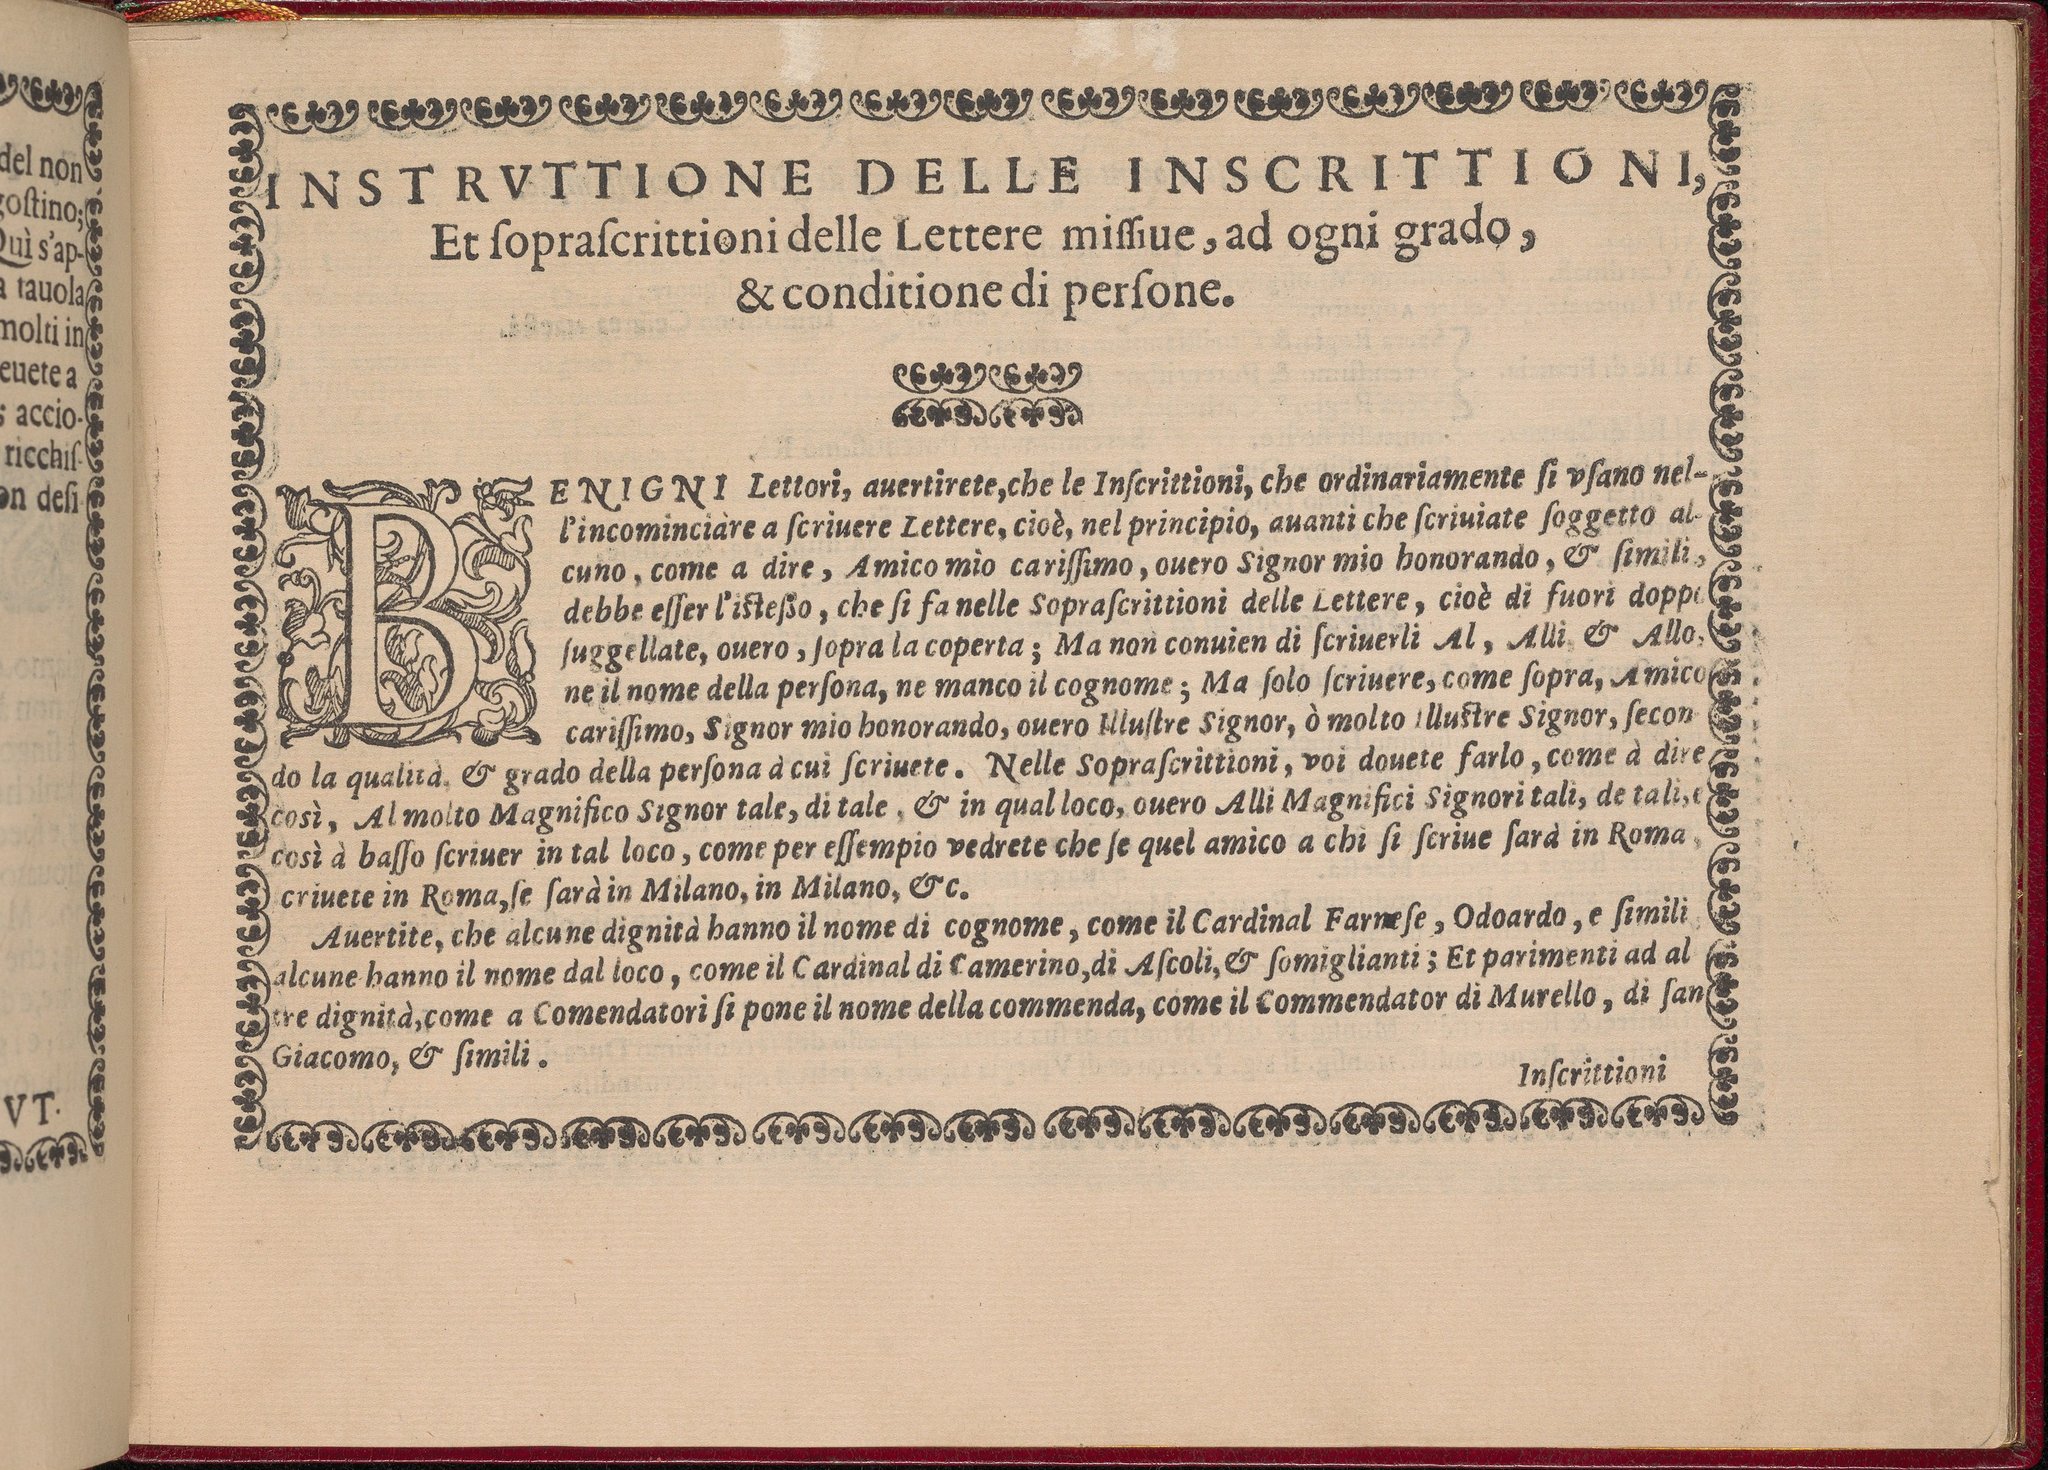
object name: book print ornament architecture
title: Ghirlanda: Di sei vaghi fiori scielti da piu famosi Giardini d'Italia, page 4 (recto)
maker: pietro paulo tozzi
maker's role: designer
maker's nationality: italian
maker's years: 1593-1628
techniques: drawing, etching